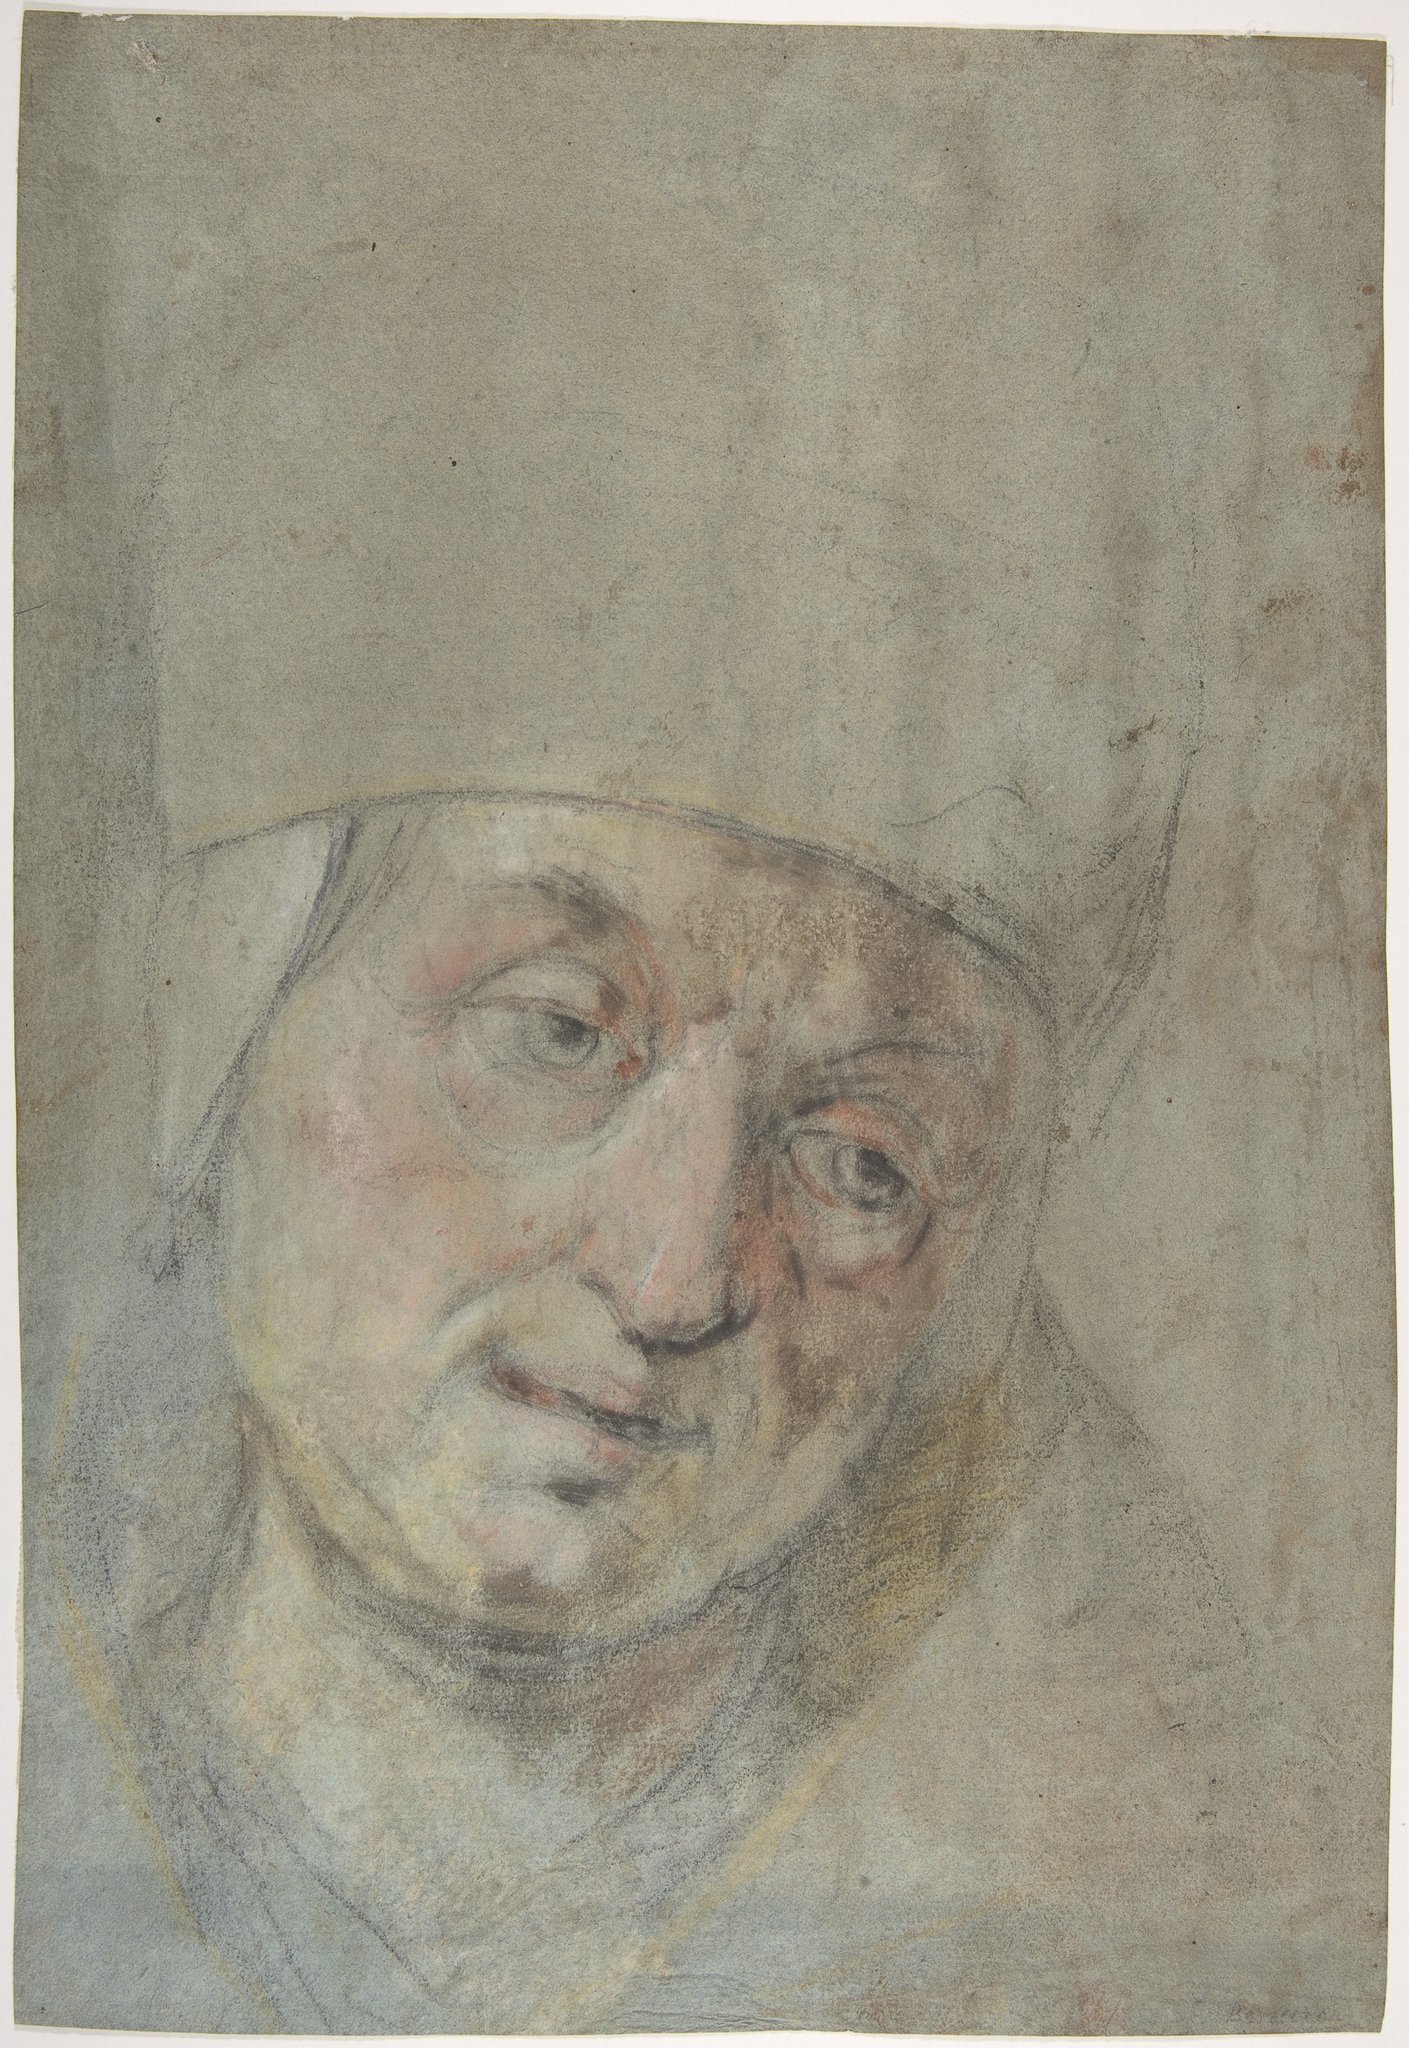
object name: drawing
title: Head of a Pope(?) (recto); Two Studies of Left Hand (verso)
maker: jacopo bassano (jacopo da ponte)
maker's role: artist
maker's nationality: italian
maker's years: 1510-1592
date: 1550-1600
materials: chalk, paper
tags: heads,popes